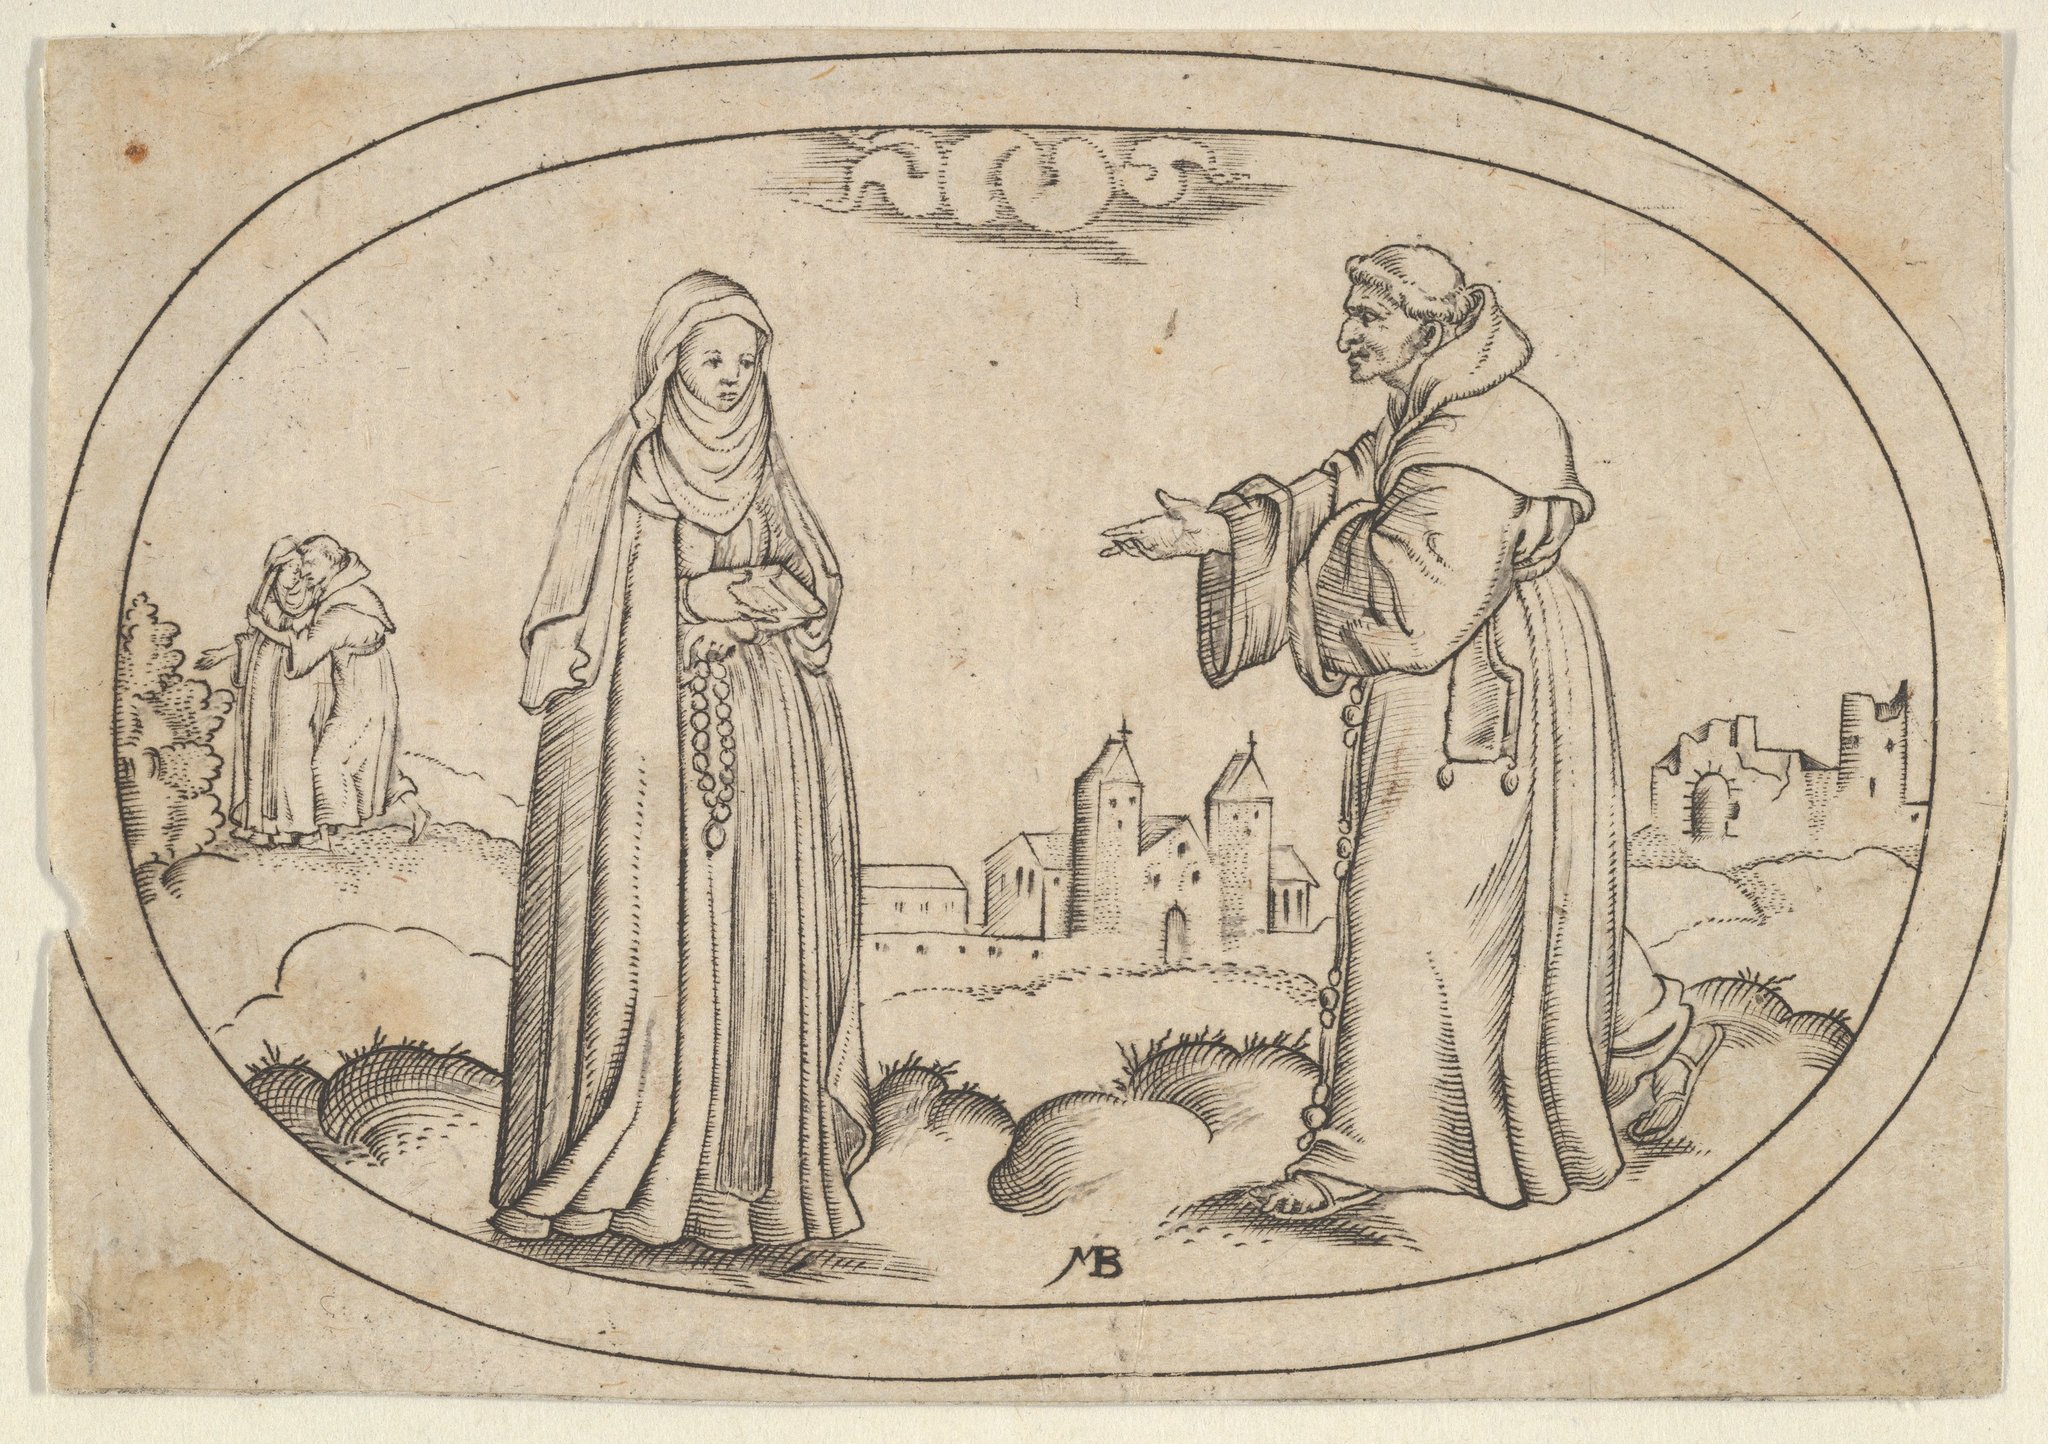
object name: print ornament architecture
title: A Nun and a Friar, from Das Bossenbüchlein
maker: mathais beitler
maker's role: artist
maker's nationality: german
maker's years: 1582-1616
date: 1582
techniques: engraving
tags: men,women